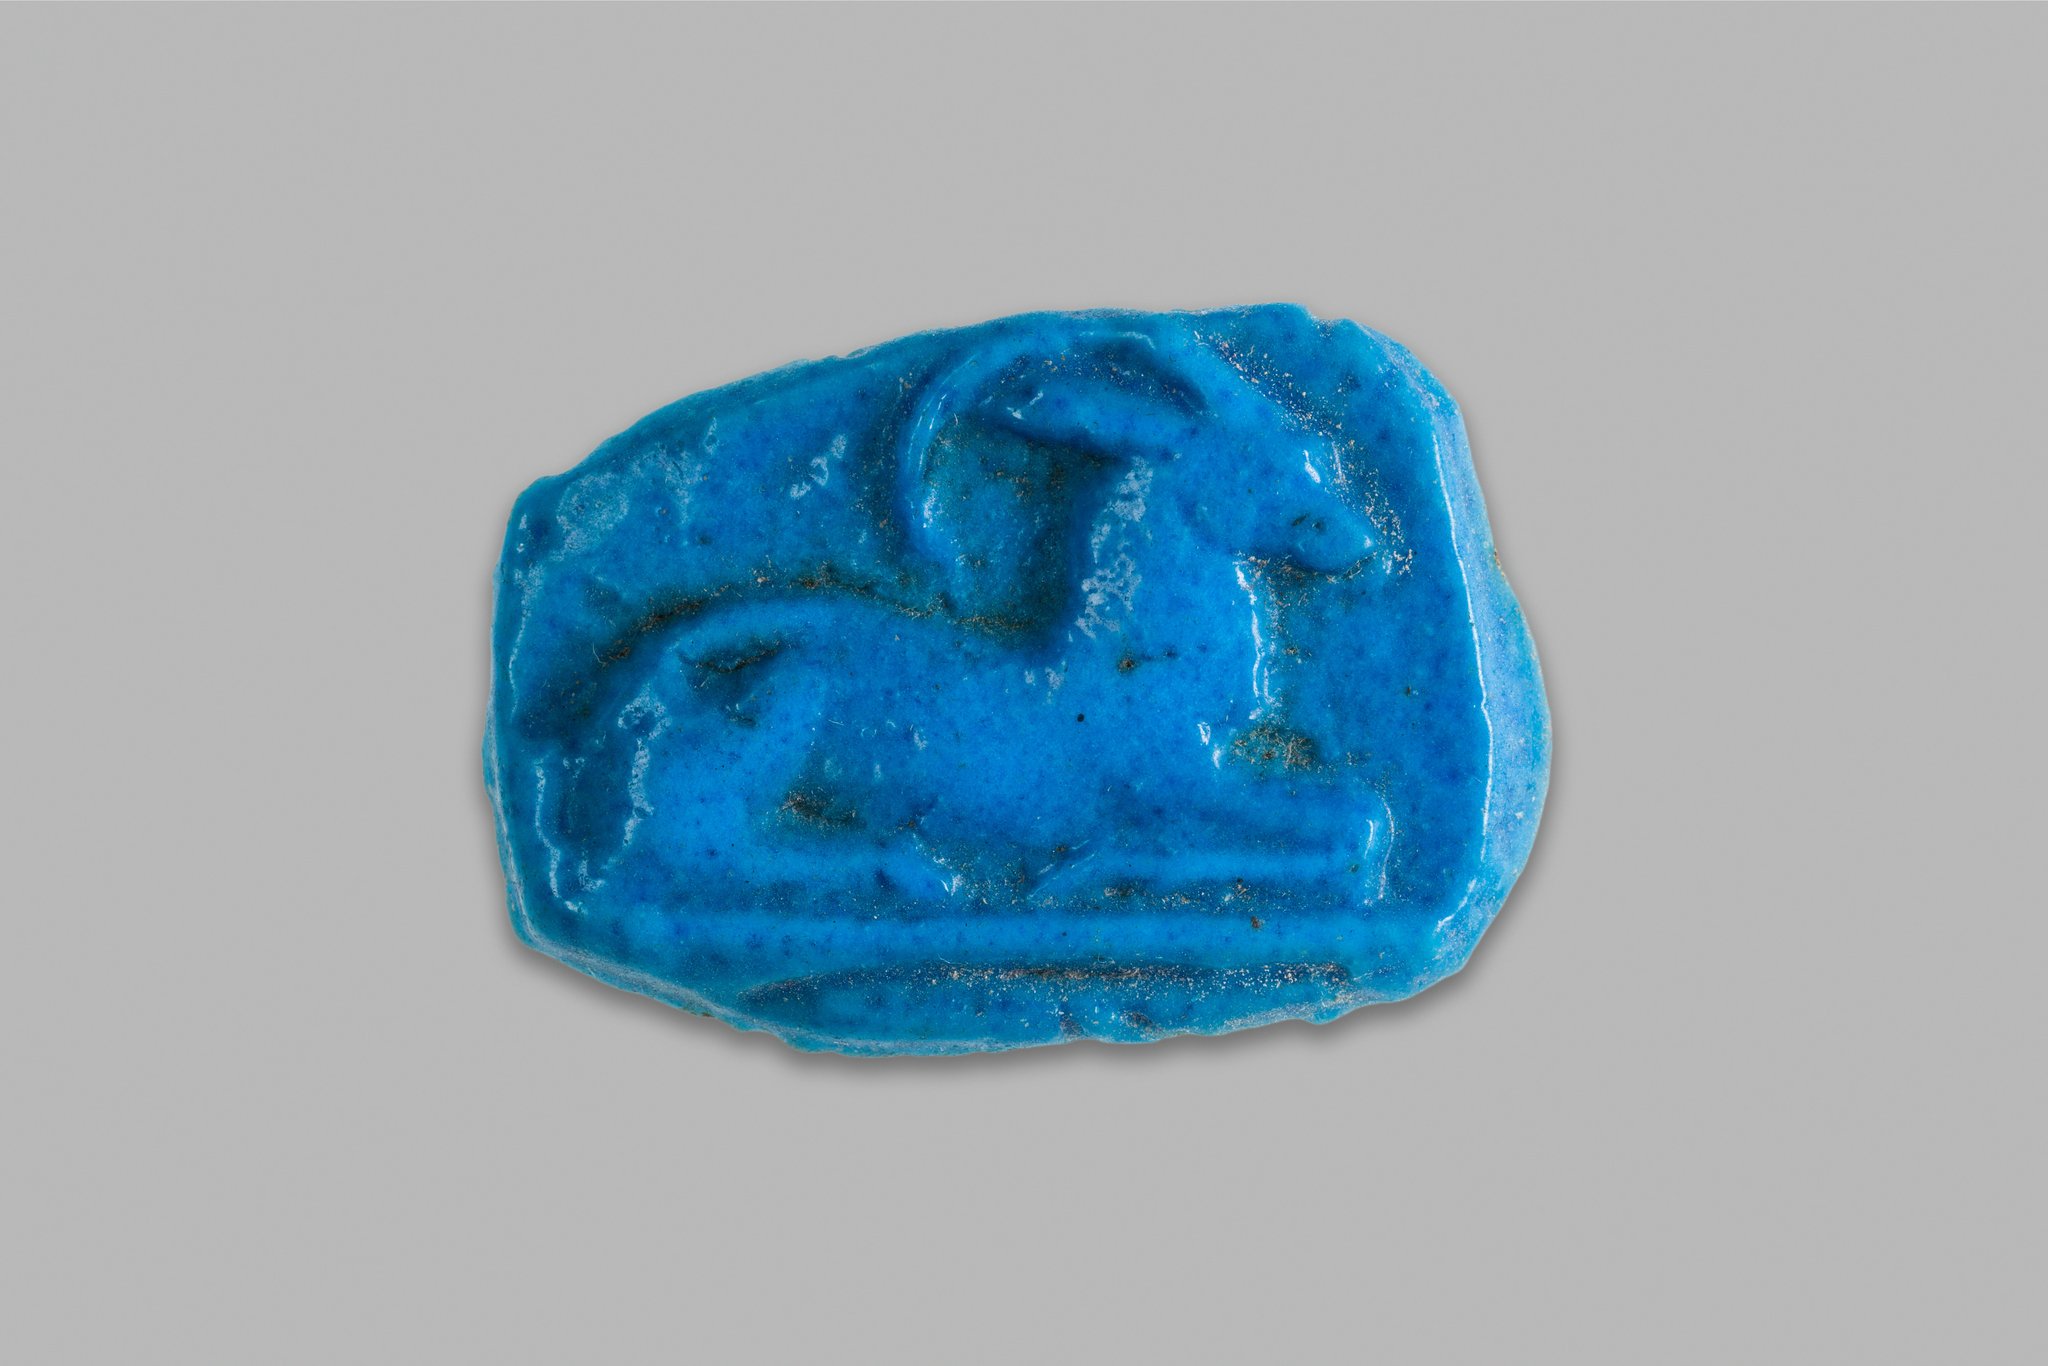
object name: foundation deposit plaque, ibex, ramesses iv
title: Plaque Bearing the Image of an Ibex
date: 1153-1147 BCE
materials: faience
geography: egypt